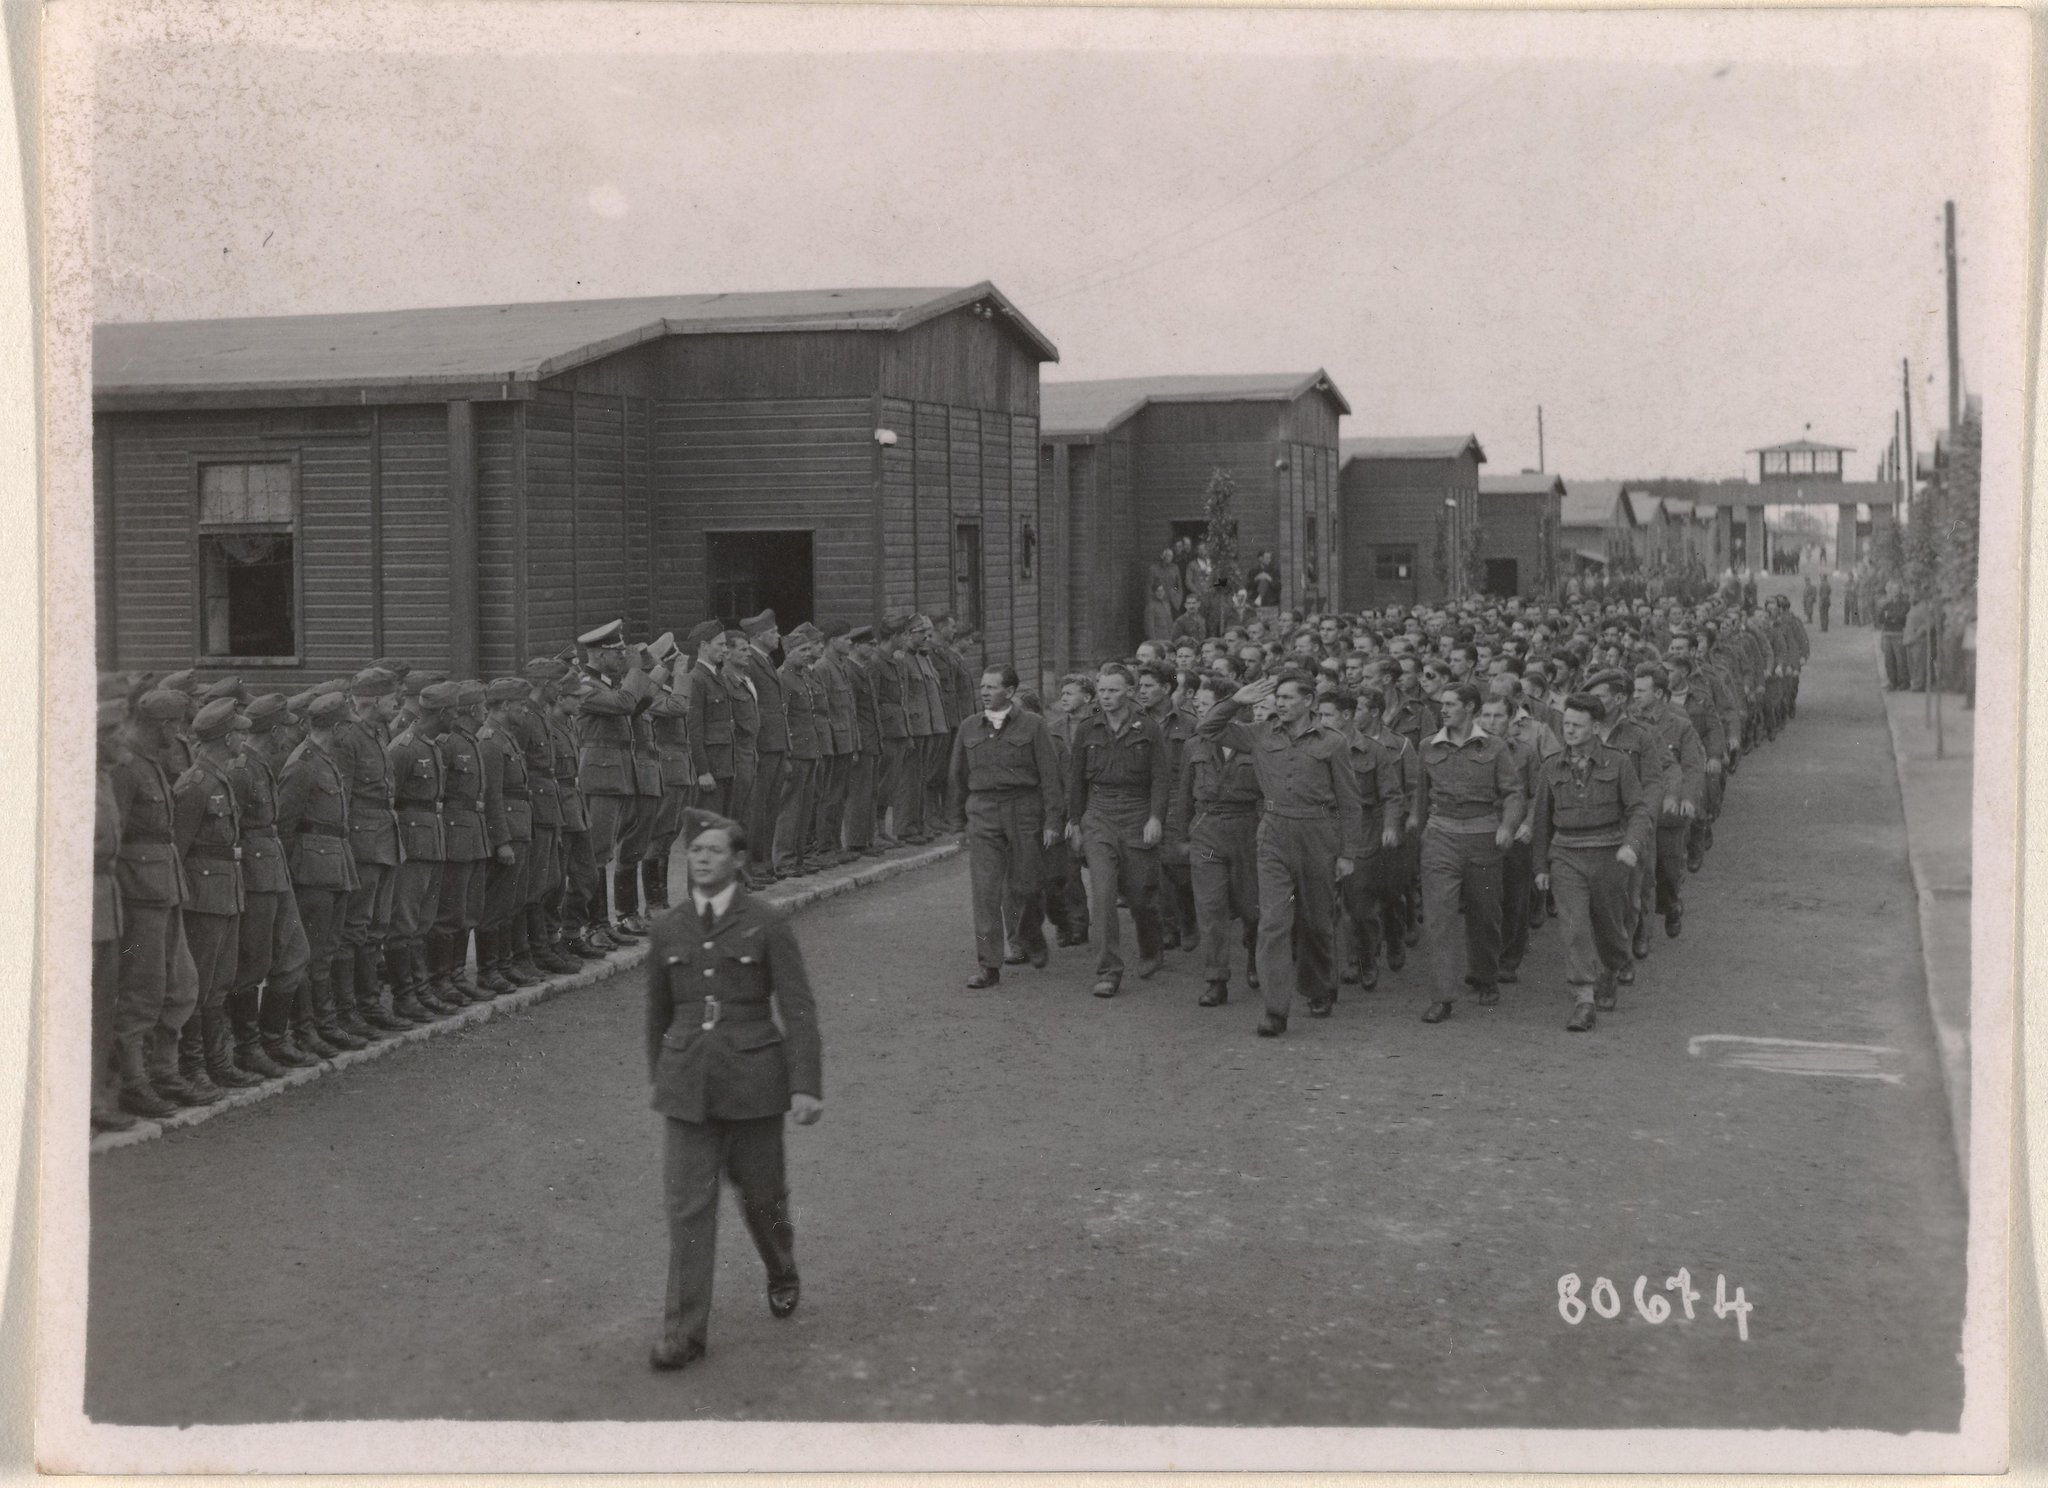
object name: photograph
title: Parade van de Nederlandse militairen door het kamp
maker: dick w.b. van maarseveen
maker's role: fotograaf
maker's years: 1905-1990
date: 1943-1945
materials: photographic support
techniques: gelatin silver print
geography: muhlberg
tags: the hague, dick w.b. van maarseveen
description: Parade van de Nederlandse militairen door het kamp op een zondag. Onderdeel van een groep foto's gemaakt door Dick van Maarseveen in het Duitse krijgsgevangenenkamp Stalag IV B in Mühlberg in de periode 1943-1945.